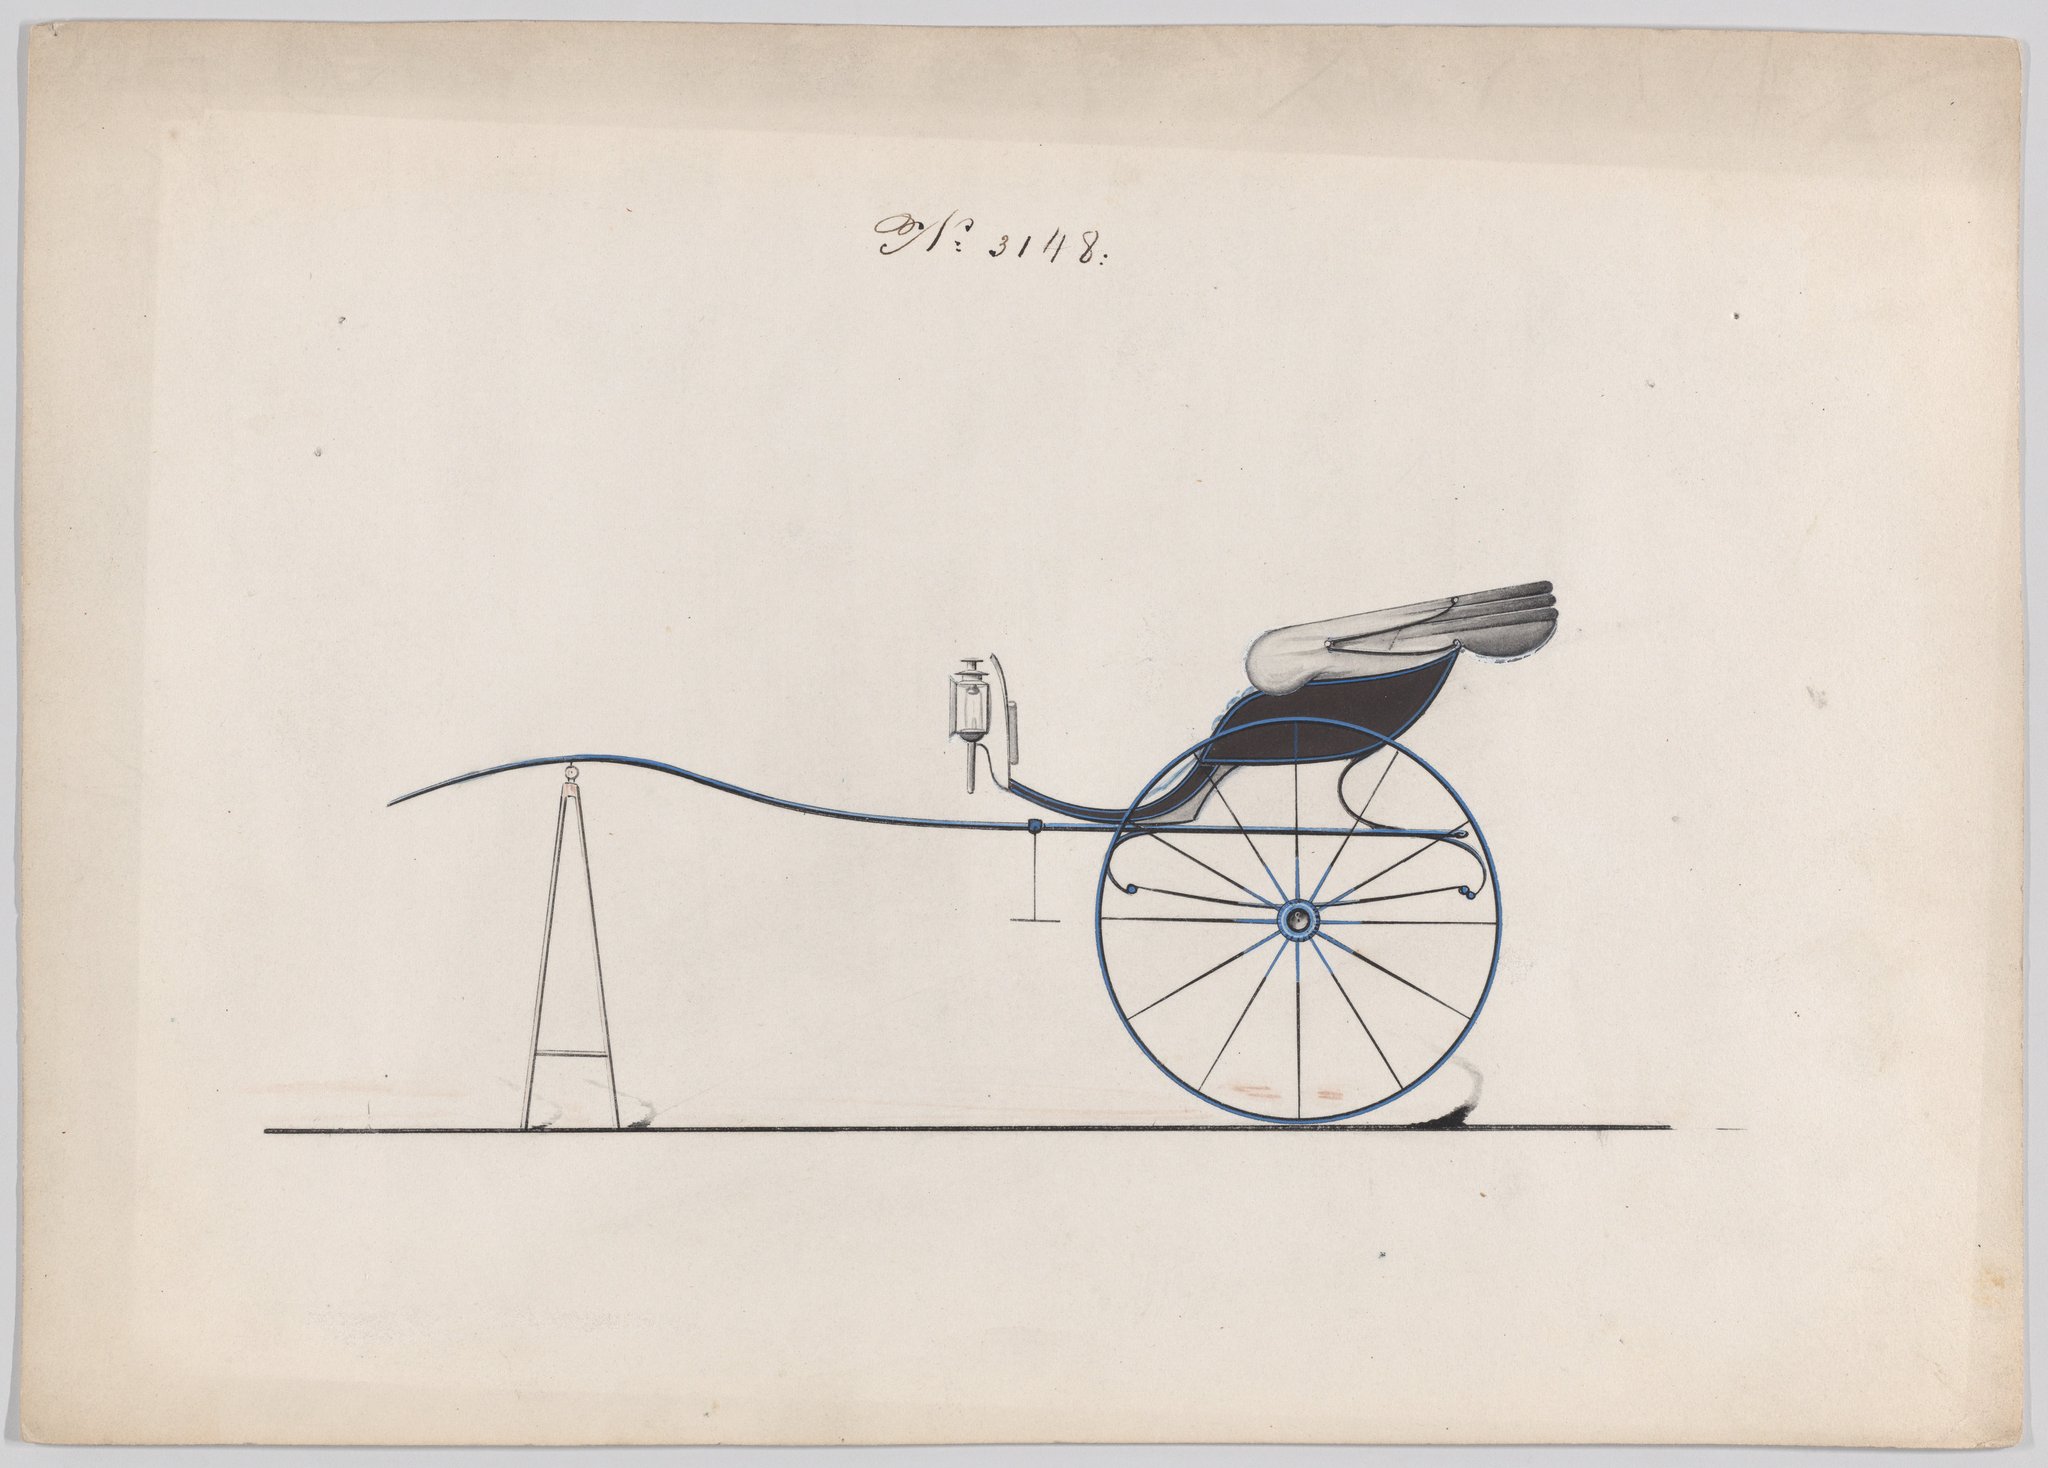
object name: drawing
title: Gig # 3148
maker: brewster & co.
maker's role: manufacturer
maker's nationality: american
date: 1875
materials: gouache, gum arabic, ink, watercolor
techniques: pen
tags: carriages